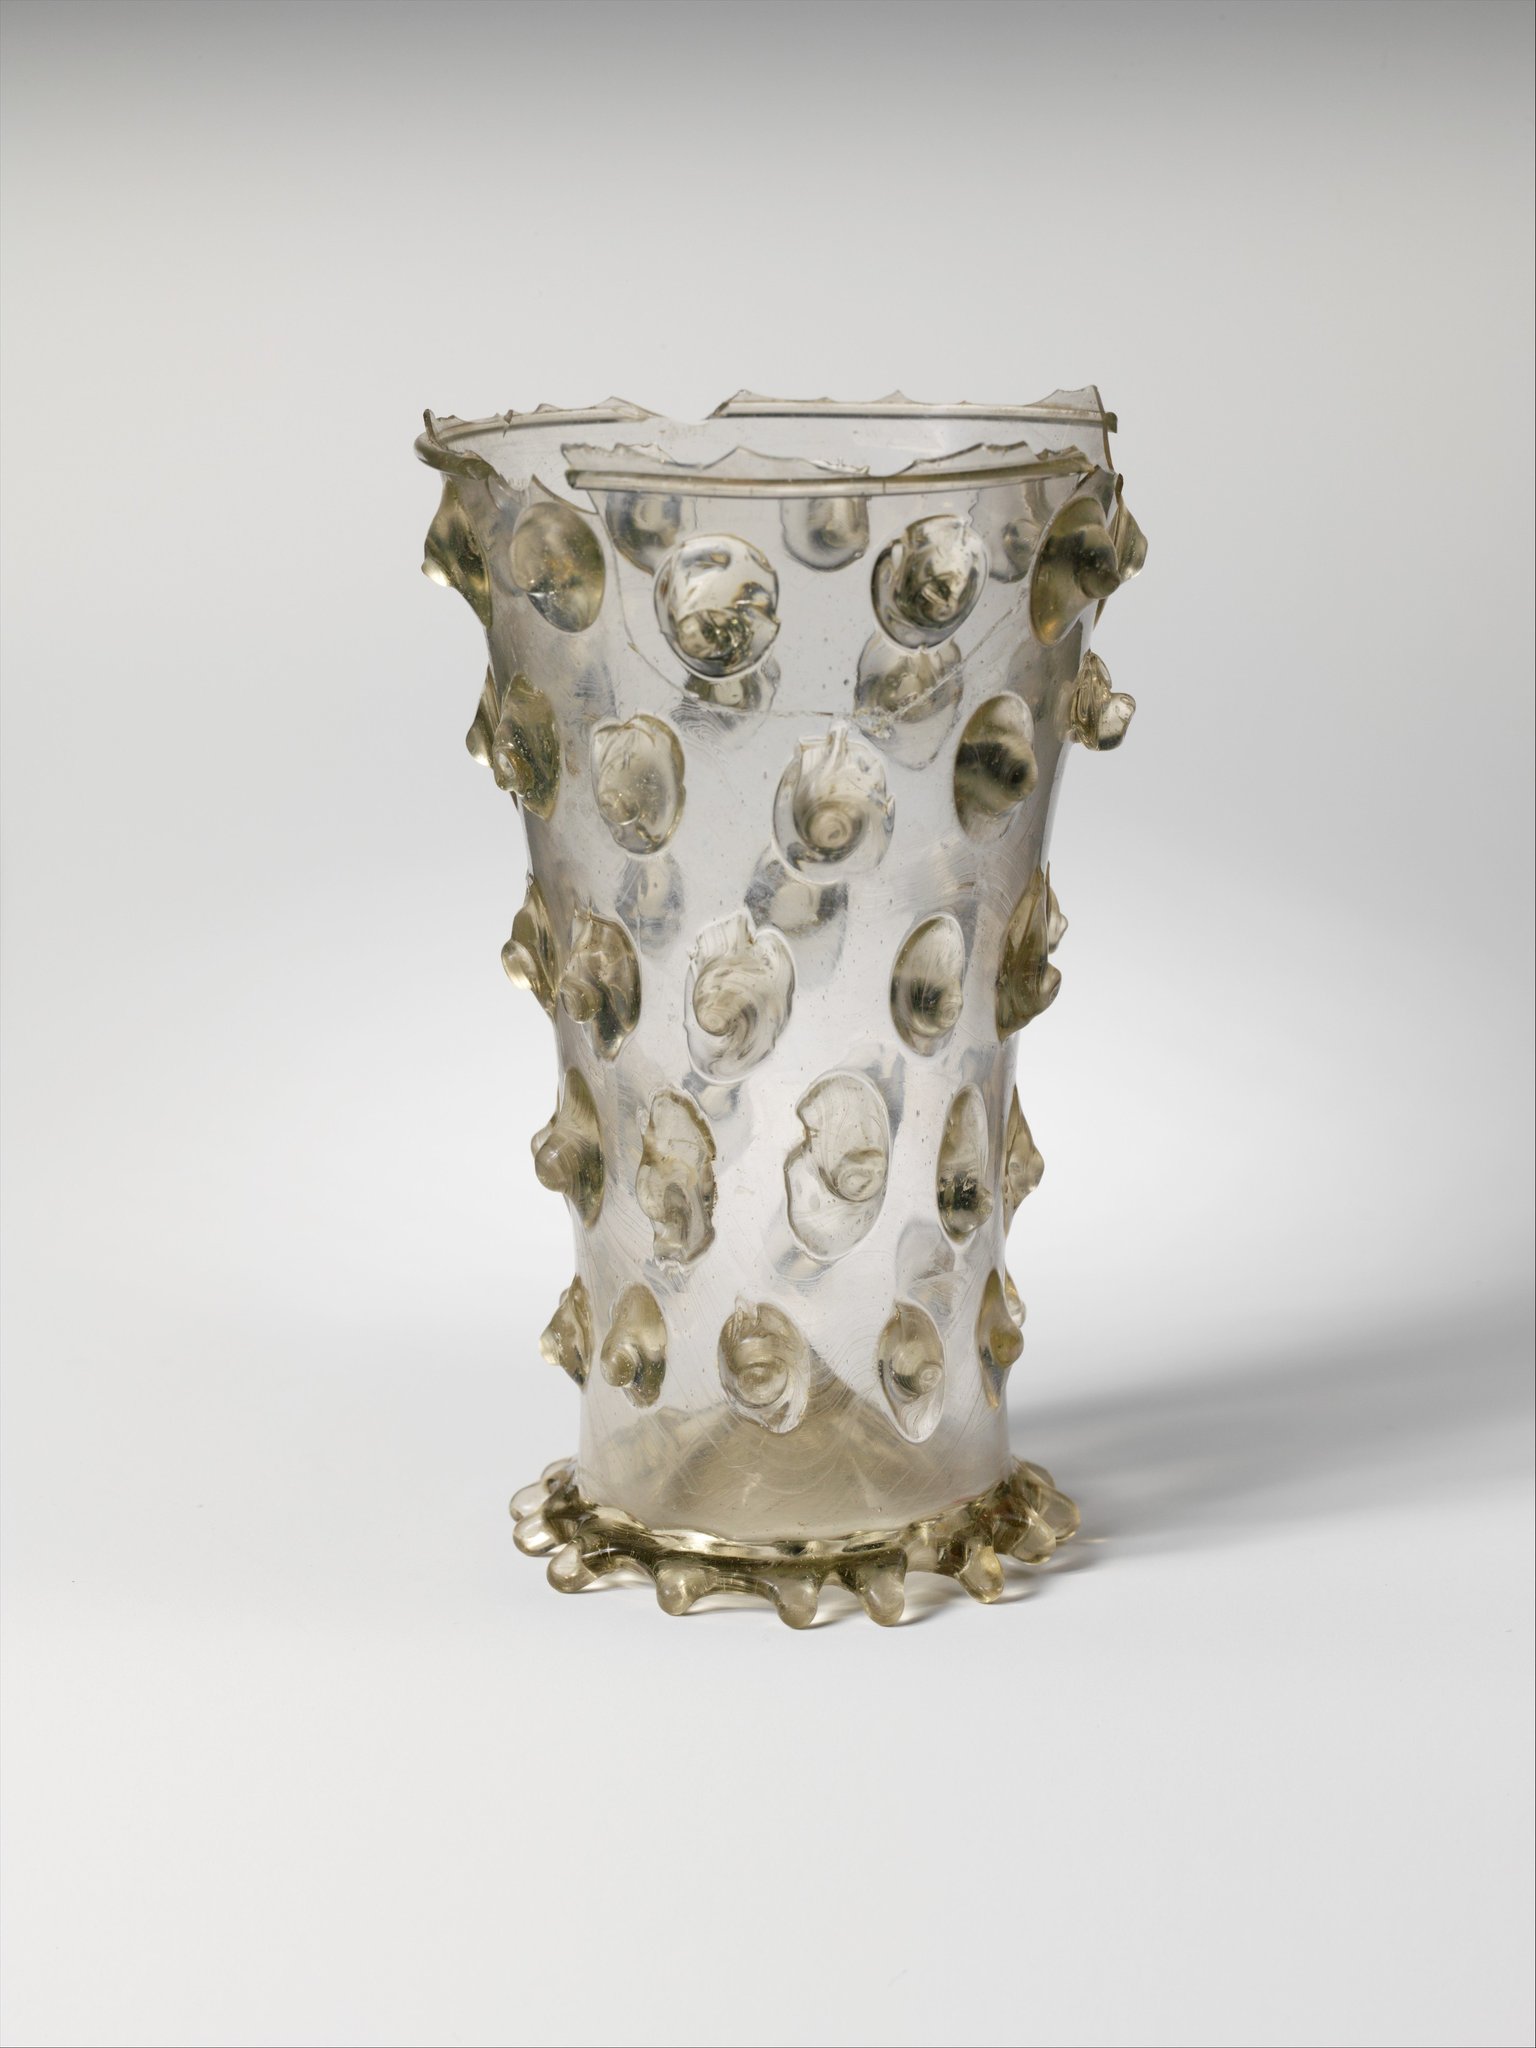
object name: beaker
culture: german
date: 1401-1500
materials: glass